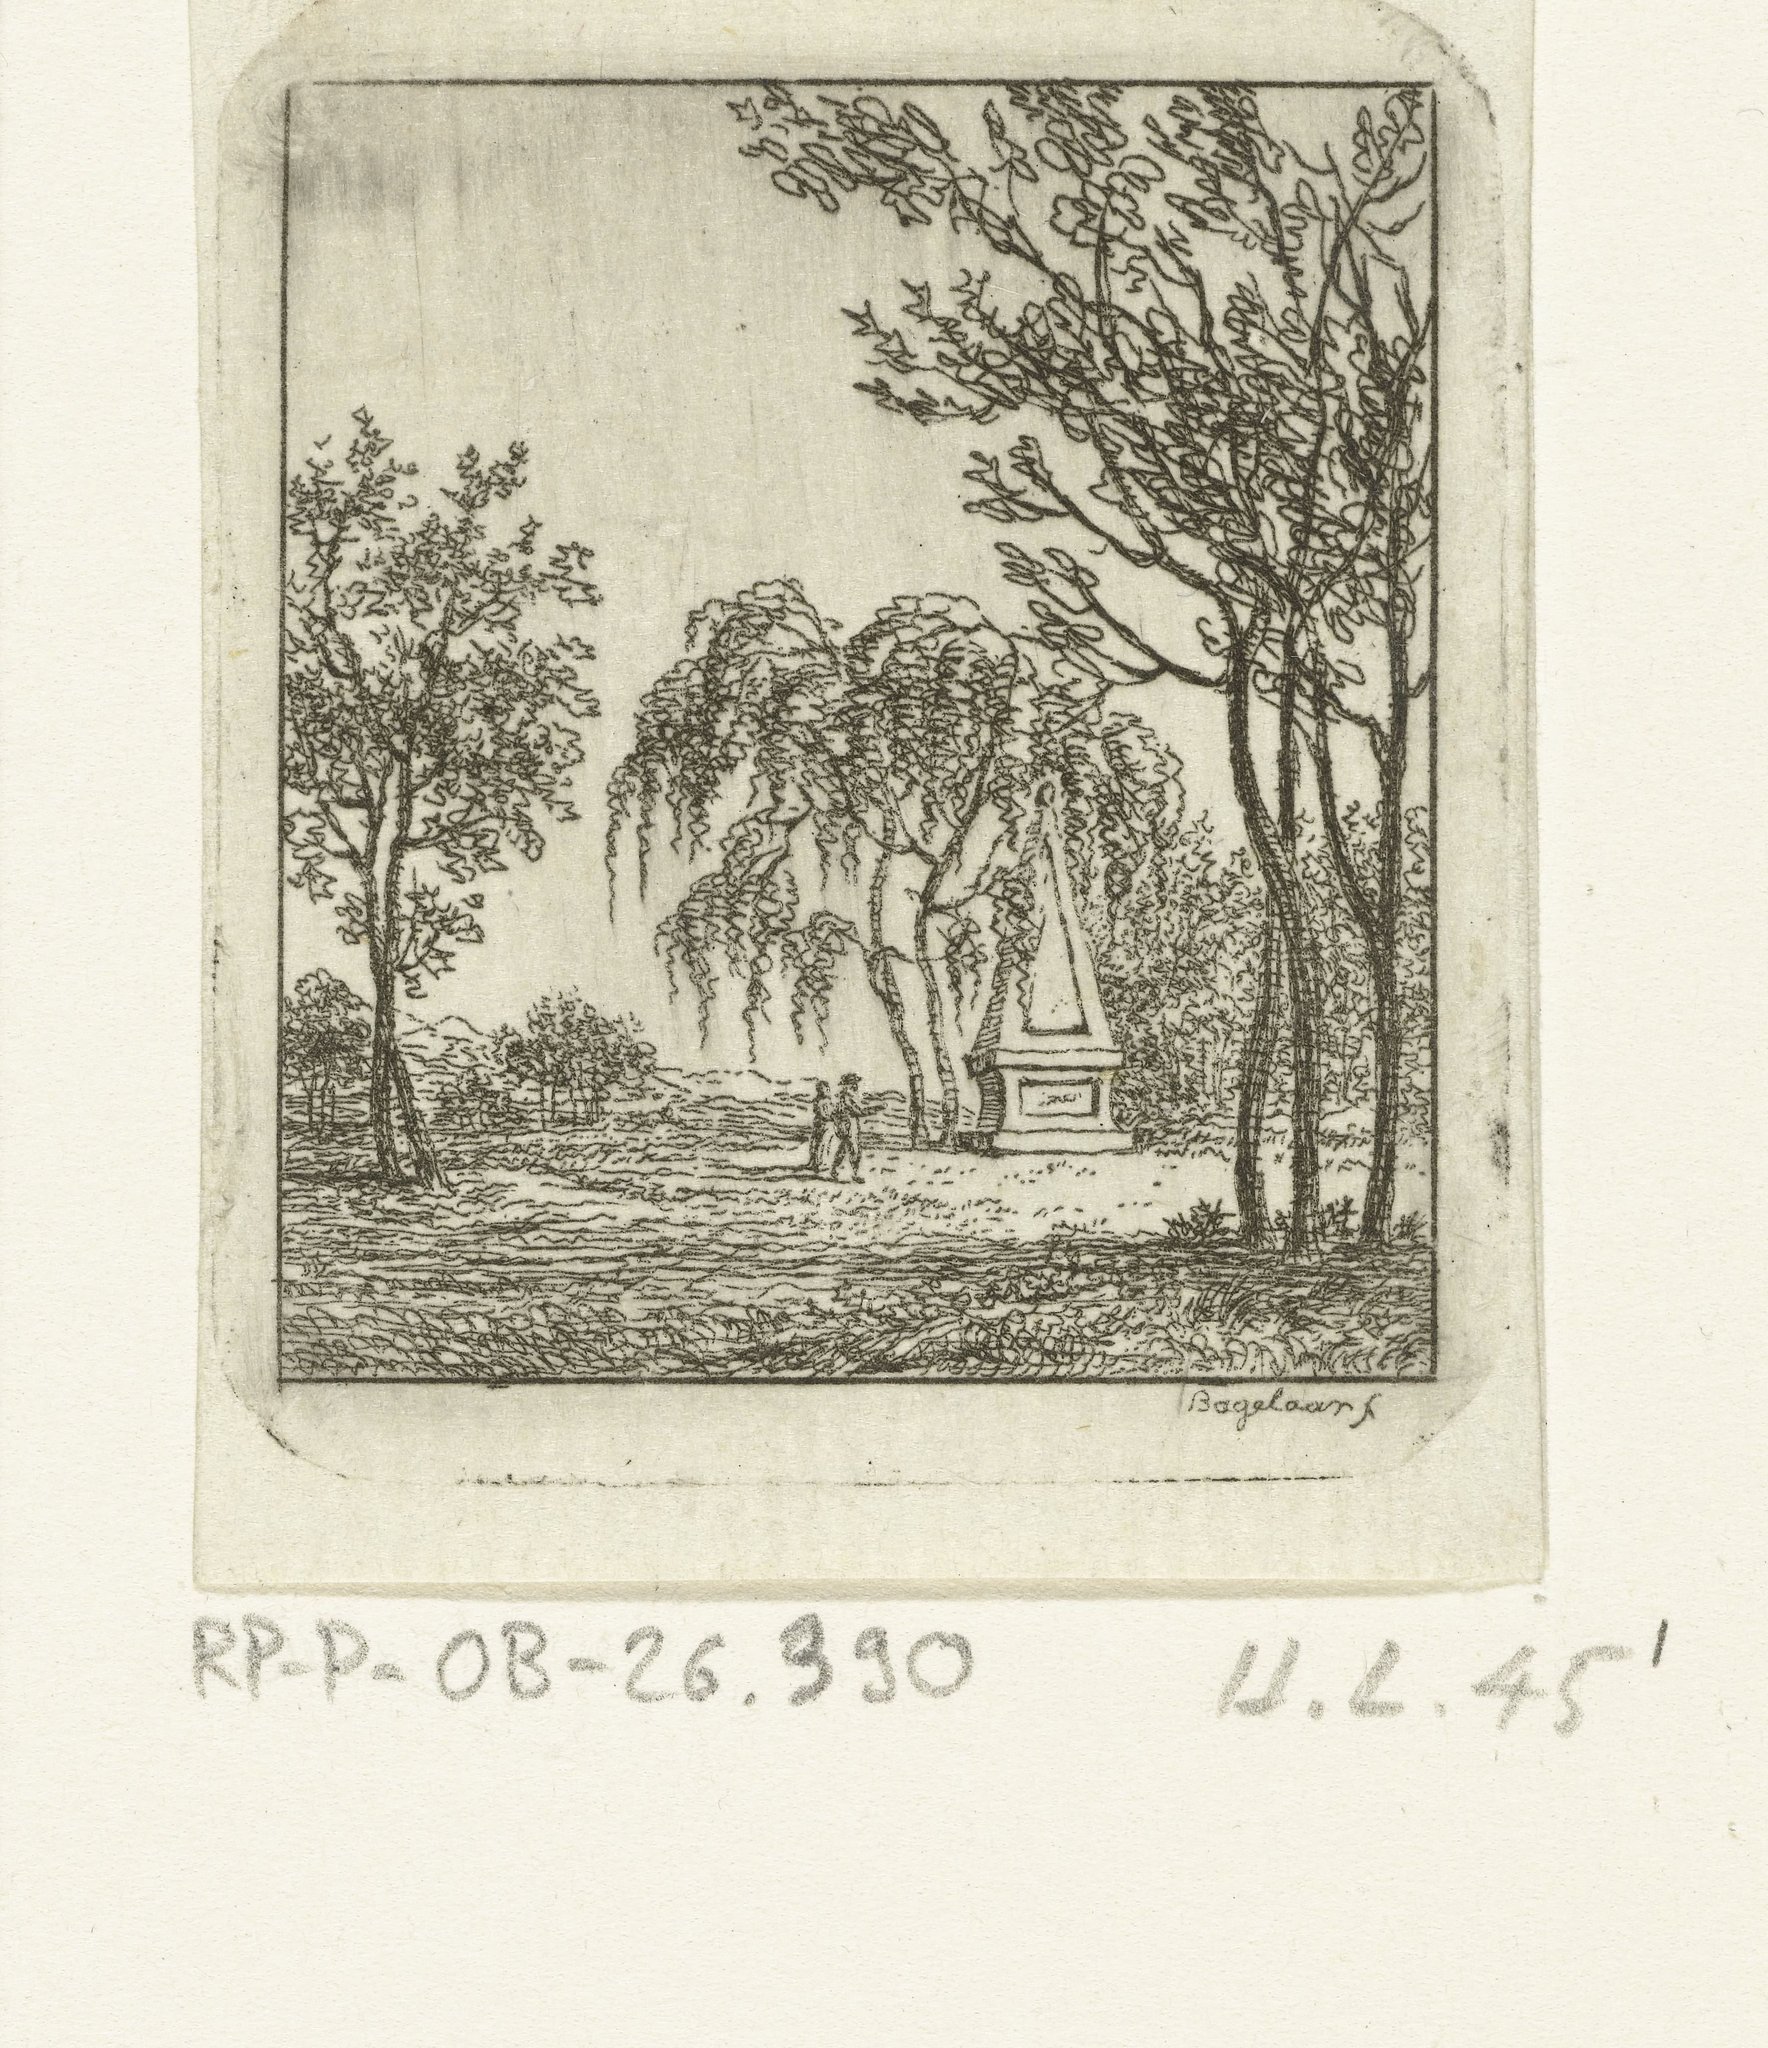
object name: print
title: Parklandschap met grafmonument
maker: ernst willem jan bagelaar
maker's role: draughtsman, print maker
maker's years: 1775-1837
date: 1798-1837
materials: paper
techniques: etching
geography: netherlands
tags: grave-building, monumental tomb